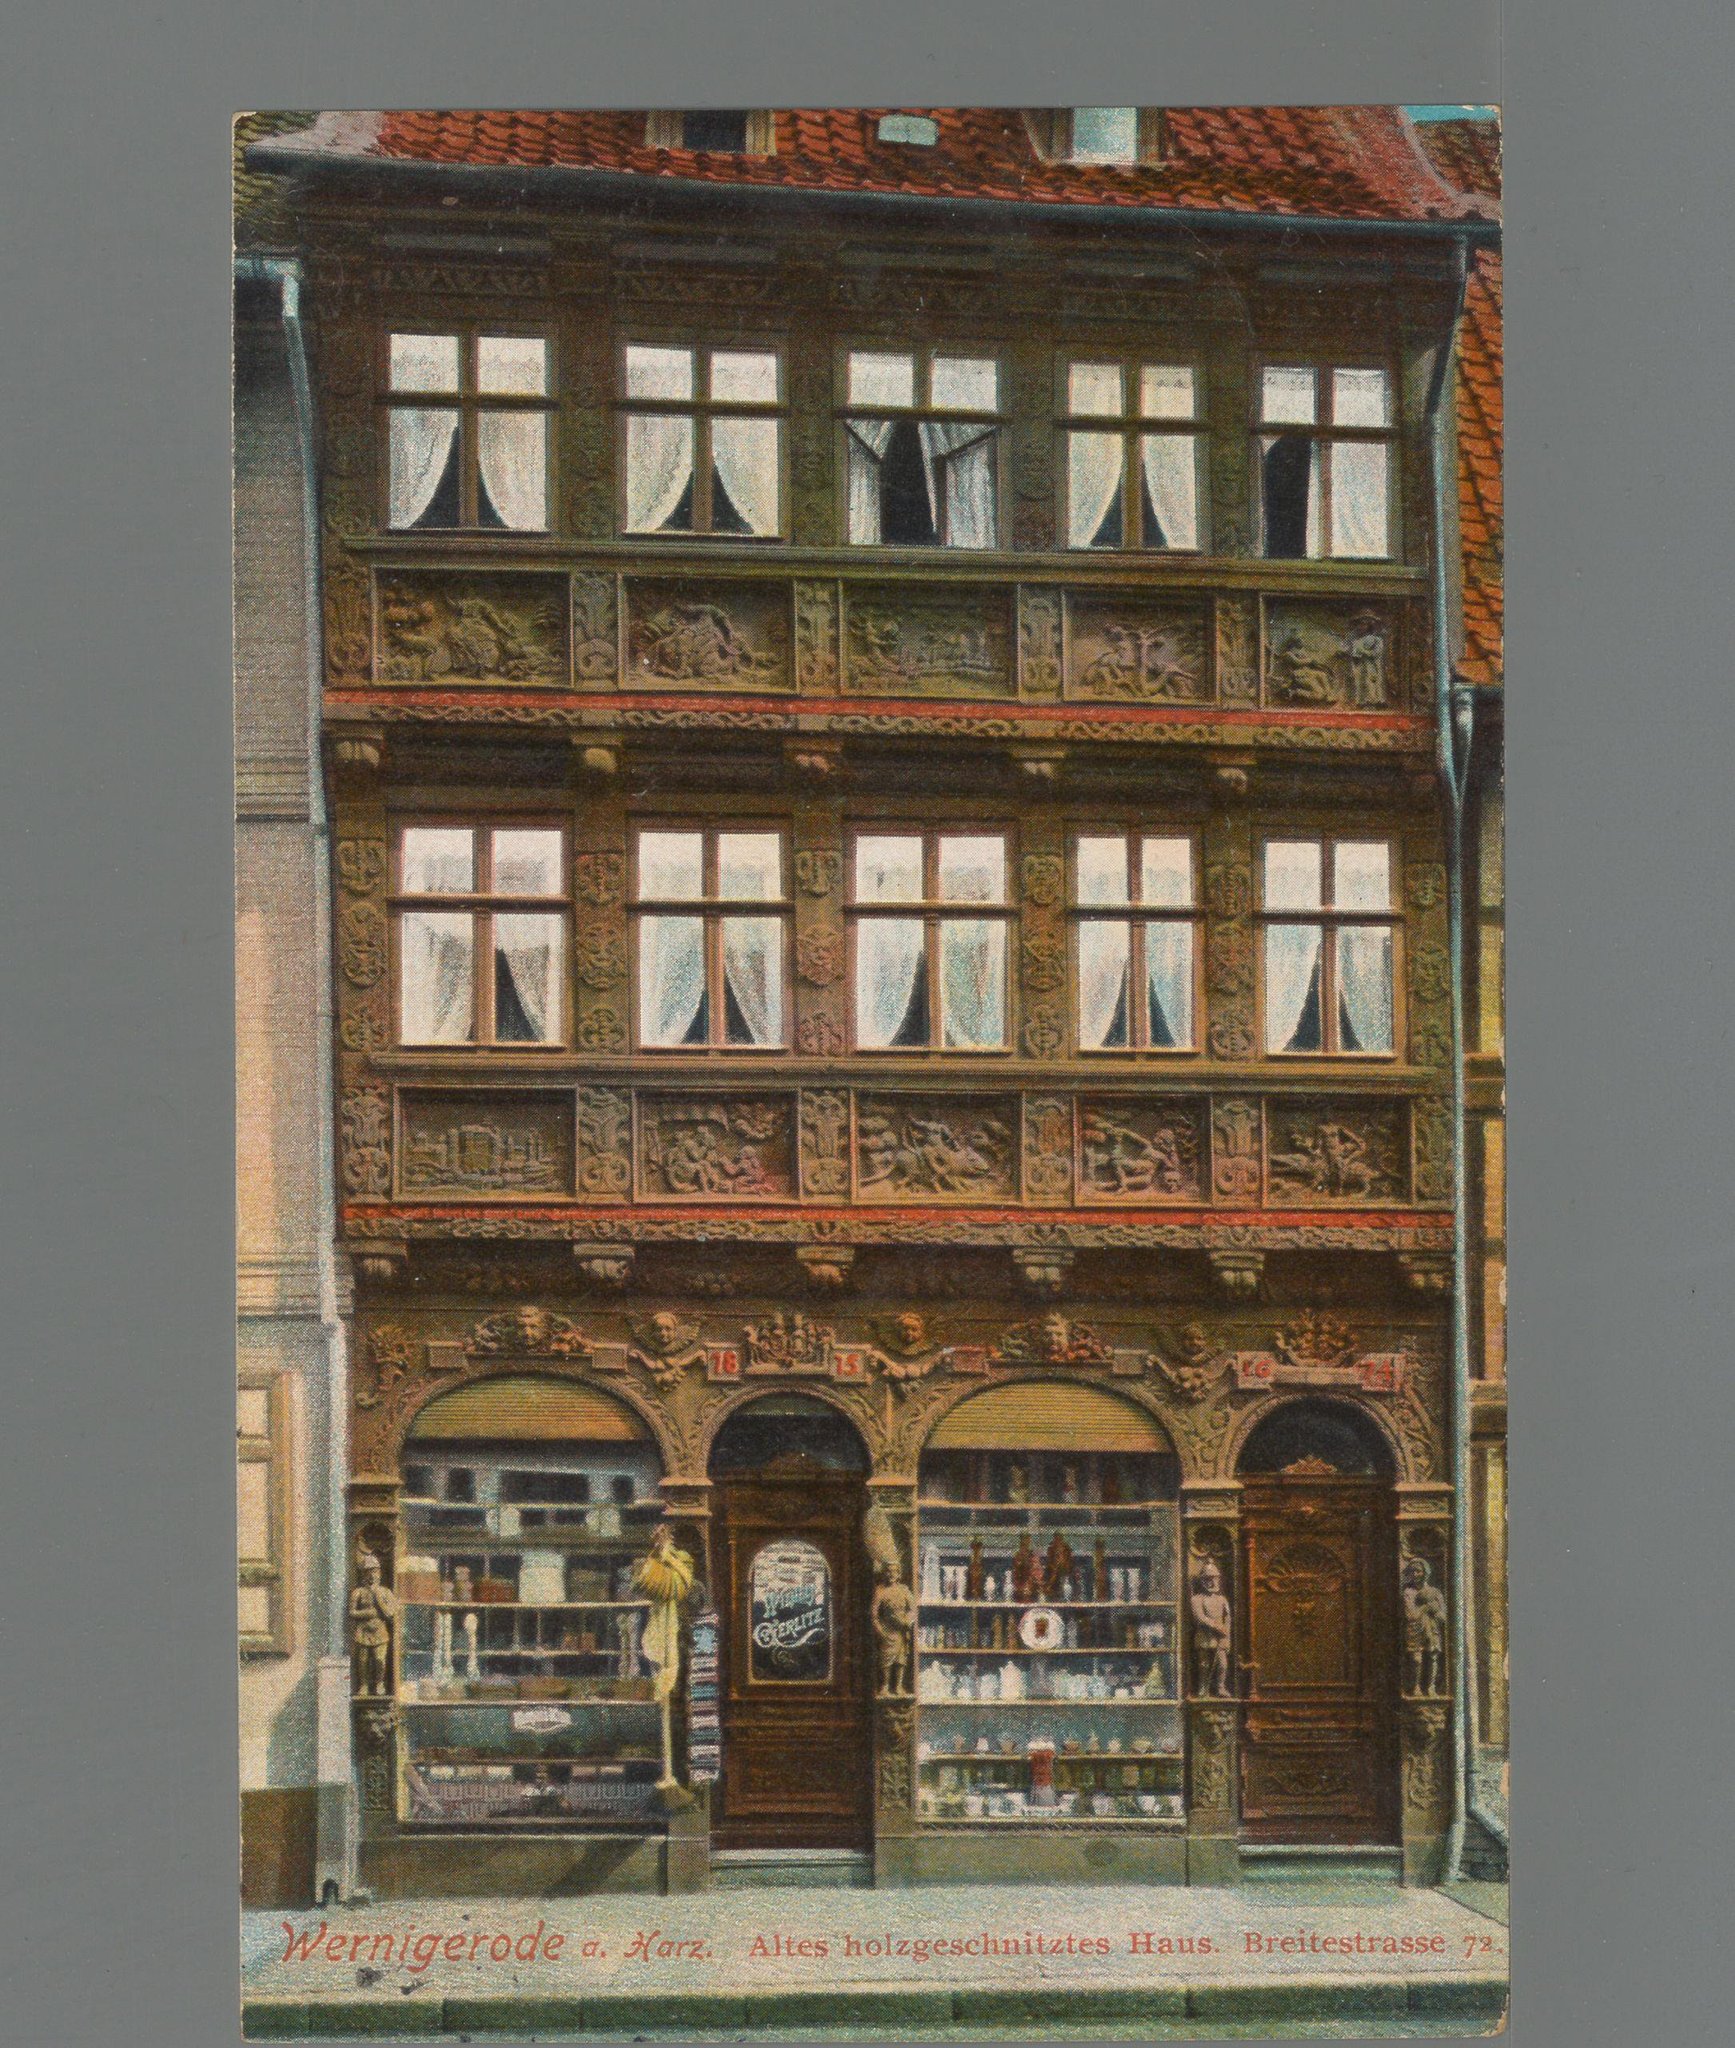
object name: ansichtkaart, prentbriefkaart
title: Wernigerode a. Harz. Altes holzgeschnitztes Haus. Breitestrasse 72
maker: louis glaser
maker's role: printer, publisher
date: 1905-1913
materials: cardboard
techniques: lithograph, writing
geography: leipzig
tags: shop, store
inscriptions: postage stamp